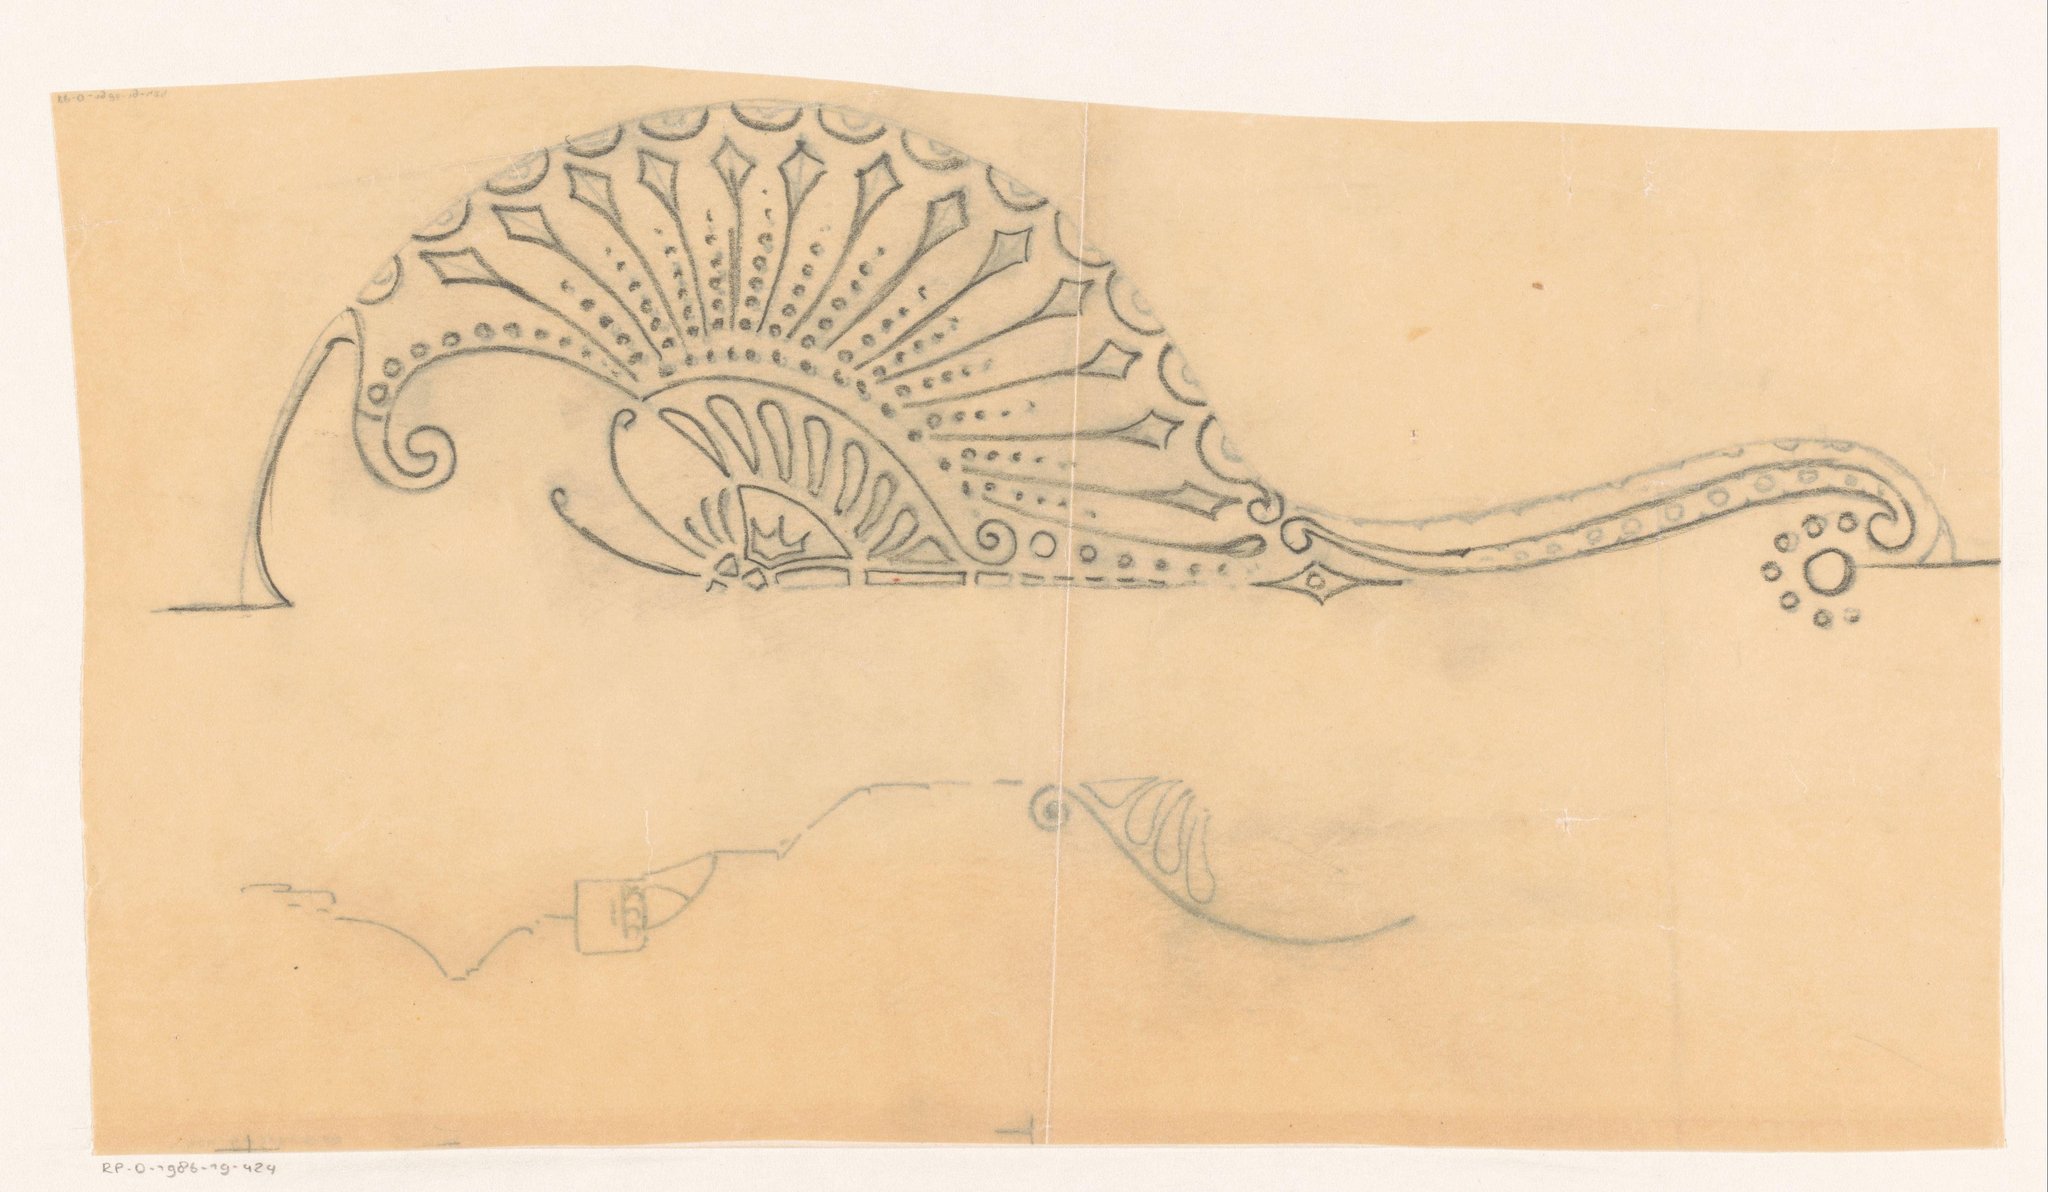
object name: drawing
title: Ornament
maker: reinier willem petrus de vries (1874-1953)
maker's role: draughtsman, print maker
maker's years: 1874-1953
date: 1884-1952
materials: pencil, paper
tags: ornaments ~ art